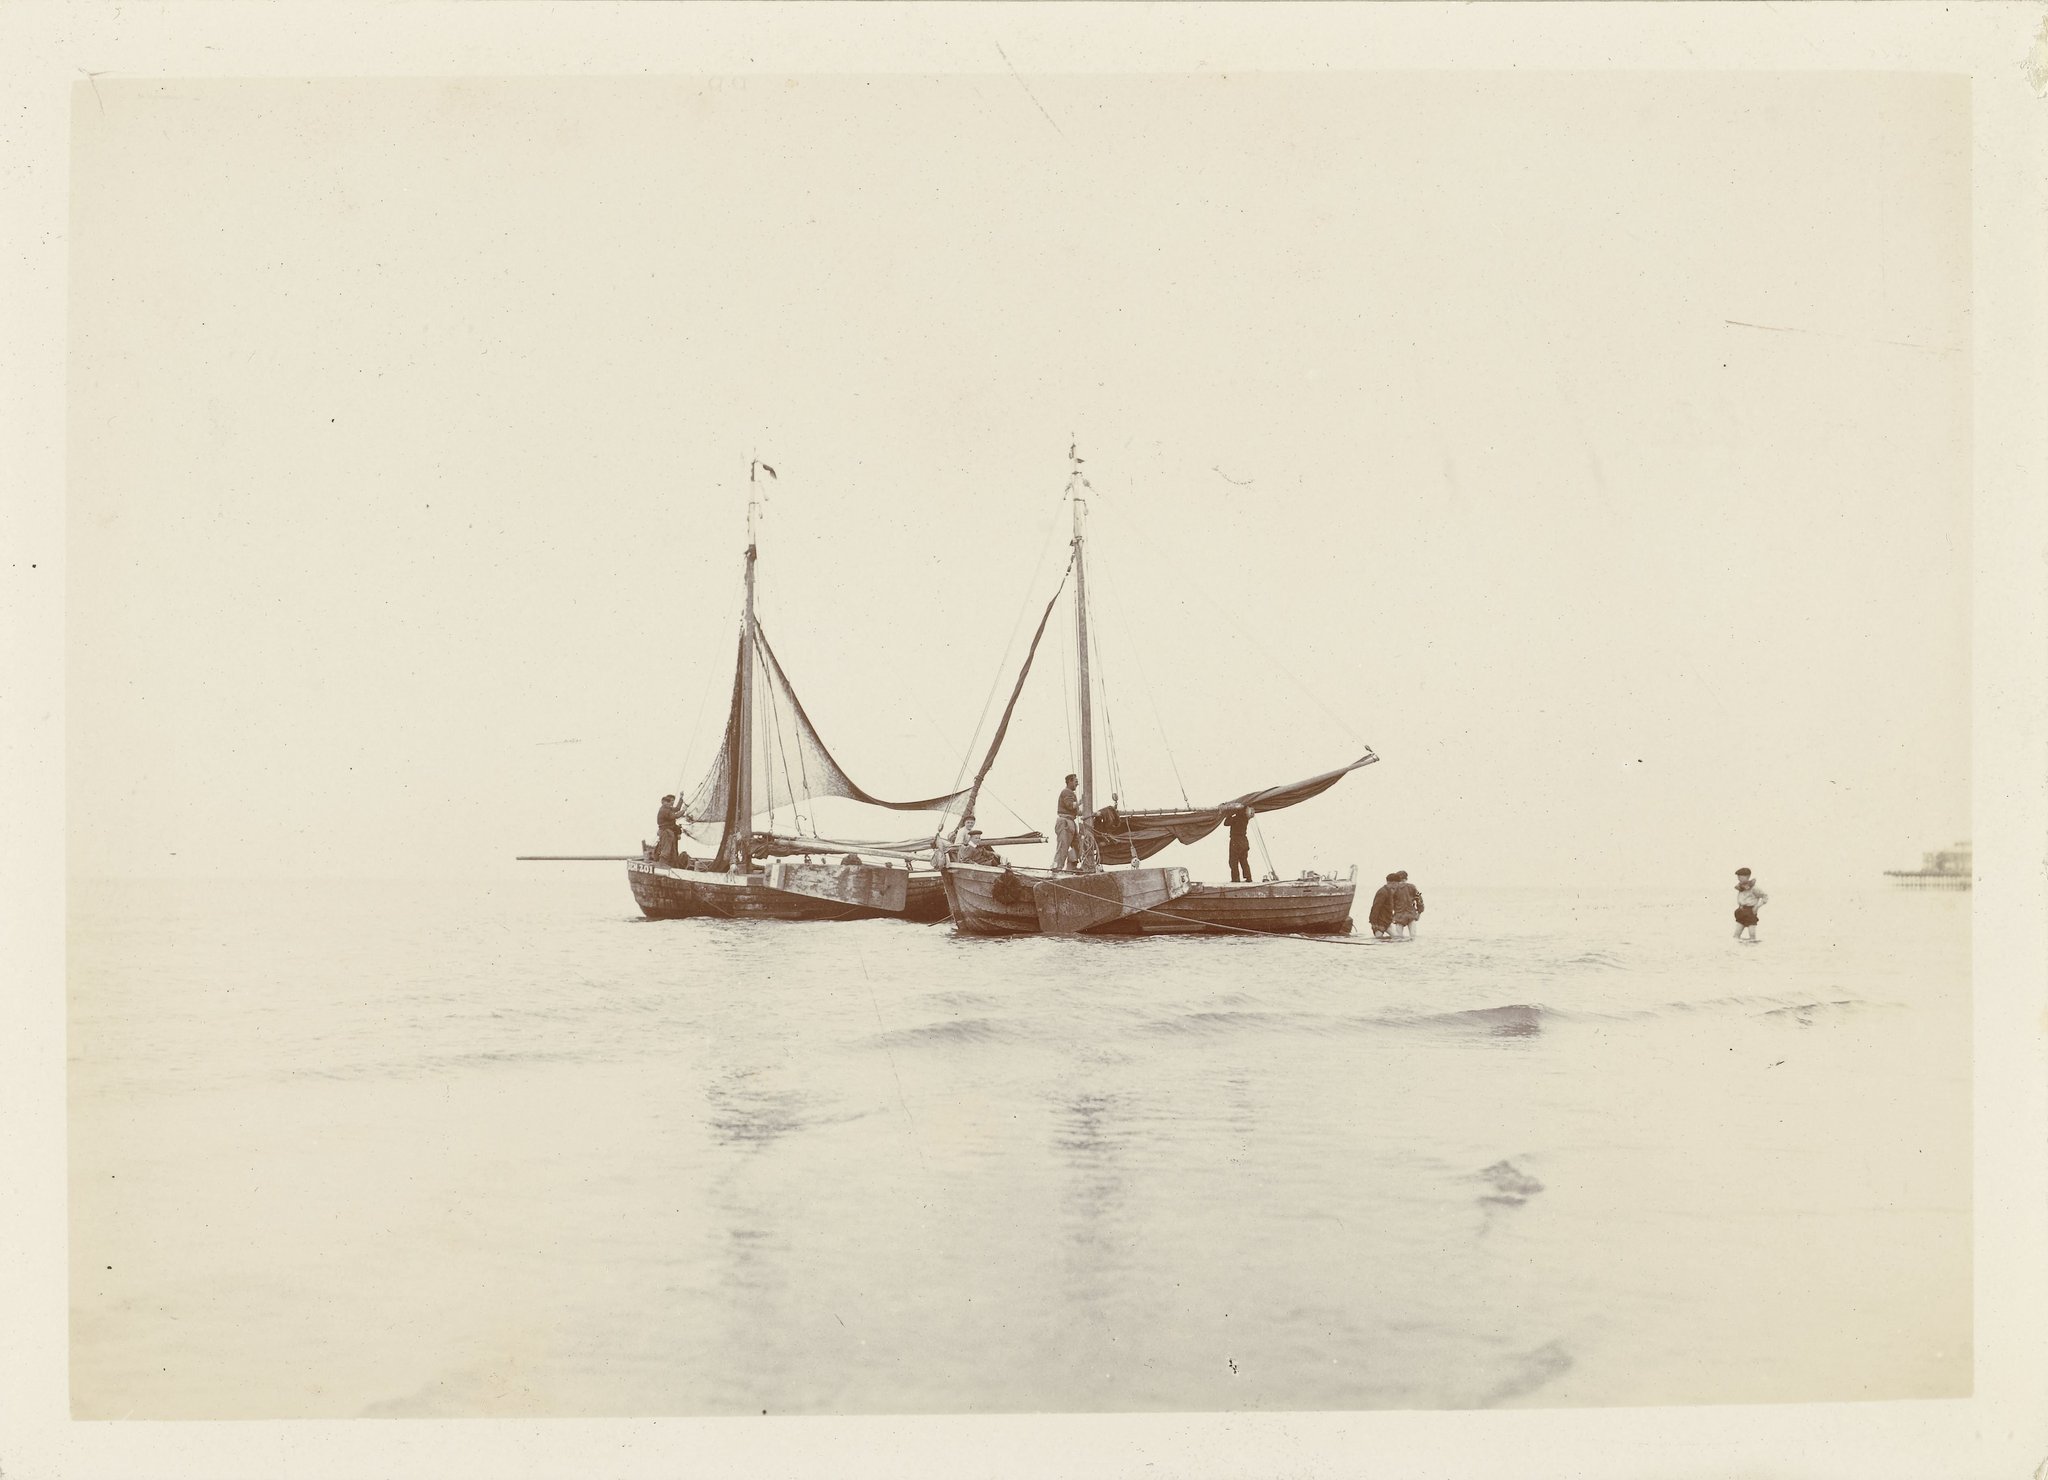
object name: photograph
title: Twee vissersschepen bij het strand van Scheveningen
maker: james higson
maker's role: politician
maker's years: 1862-1933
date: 1904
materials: paper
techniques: gelatin silver print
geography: scheveningen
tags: ships (in general)